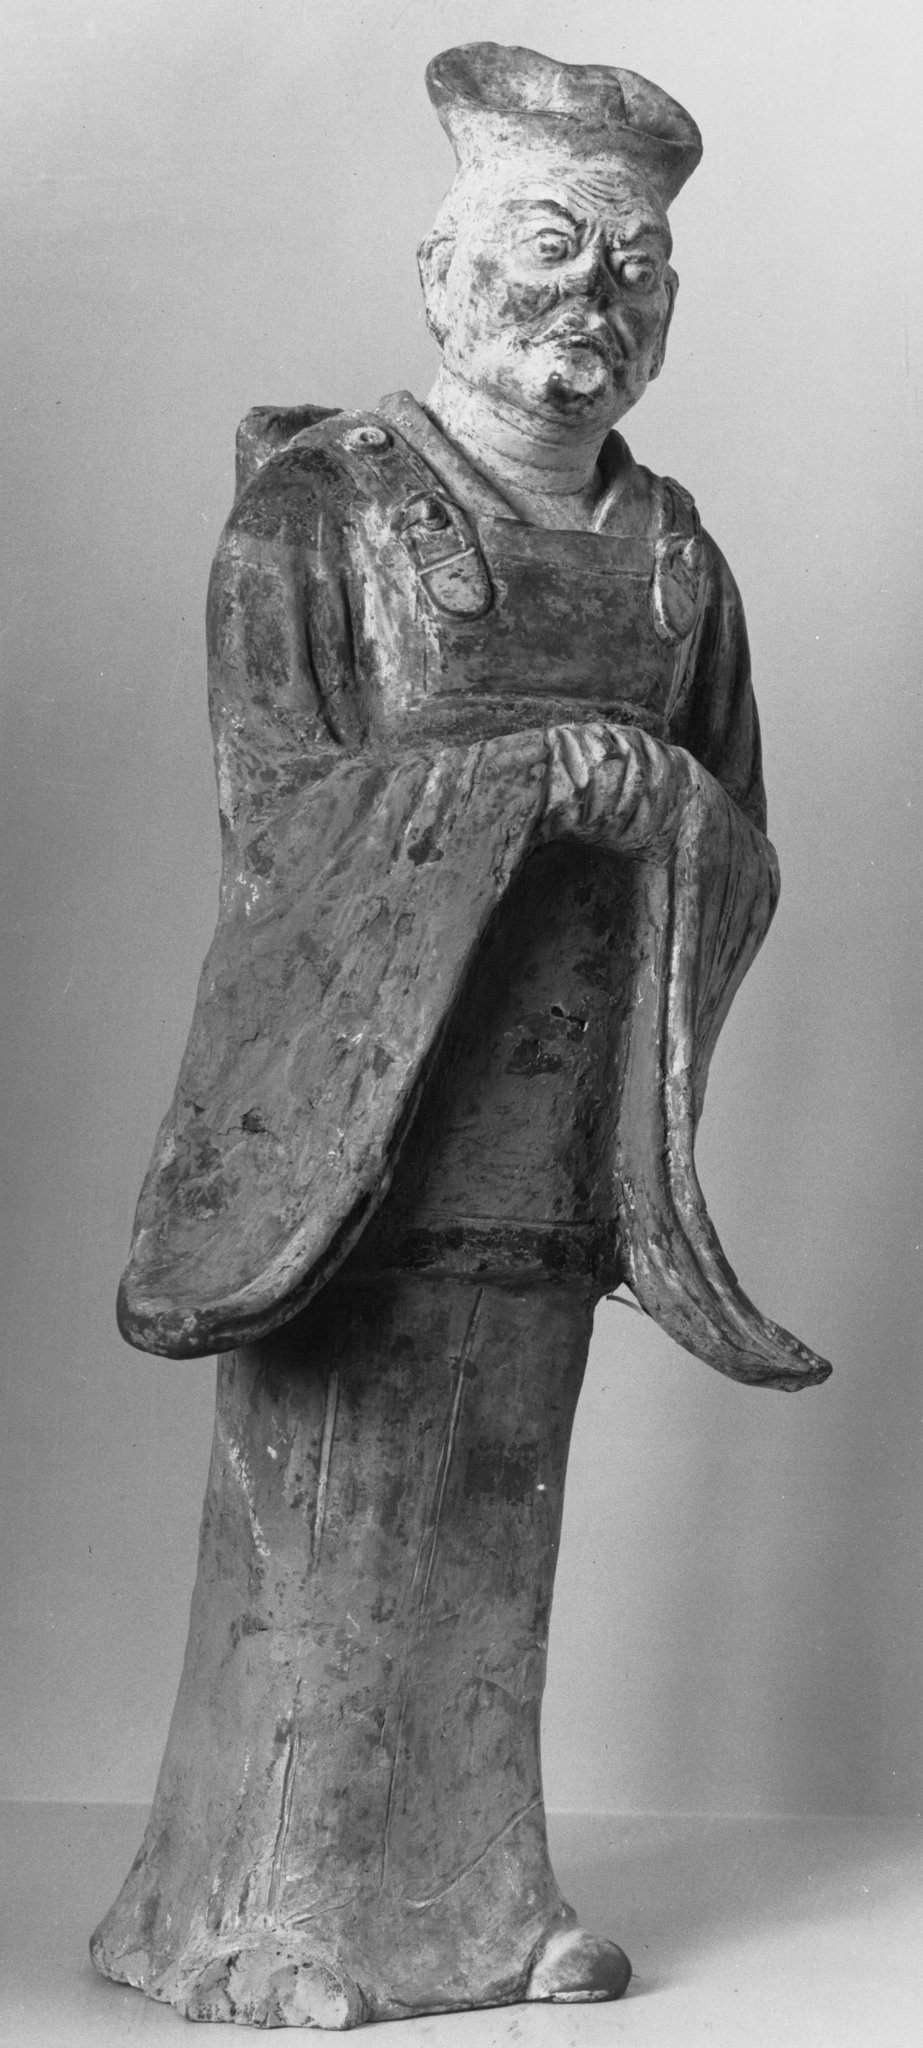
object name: figure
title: Civil official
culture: chinese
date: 501-600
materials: earthenware, pigment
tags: men